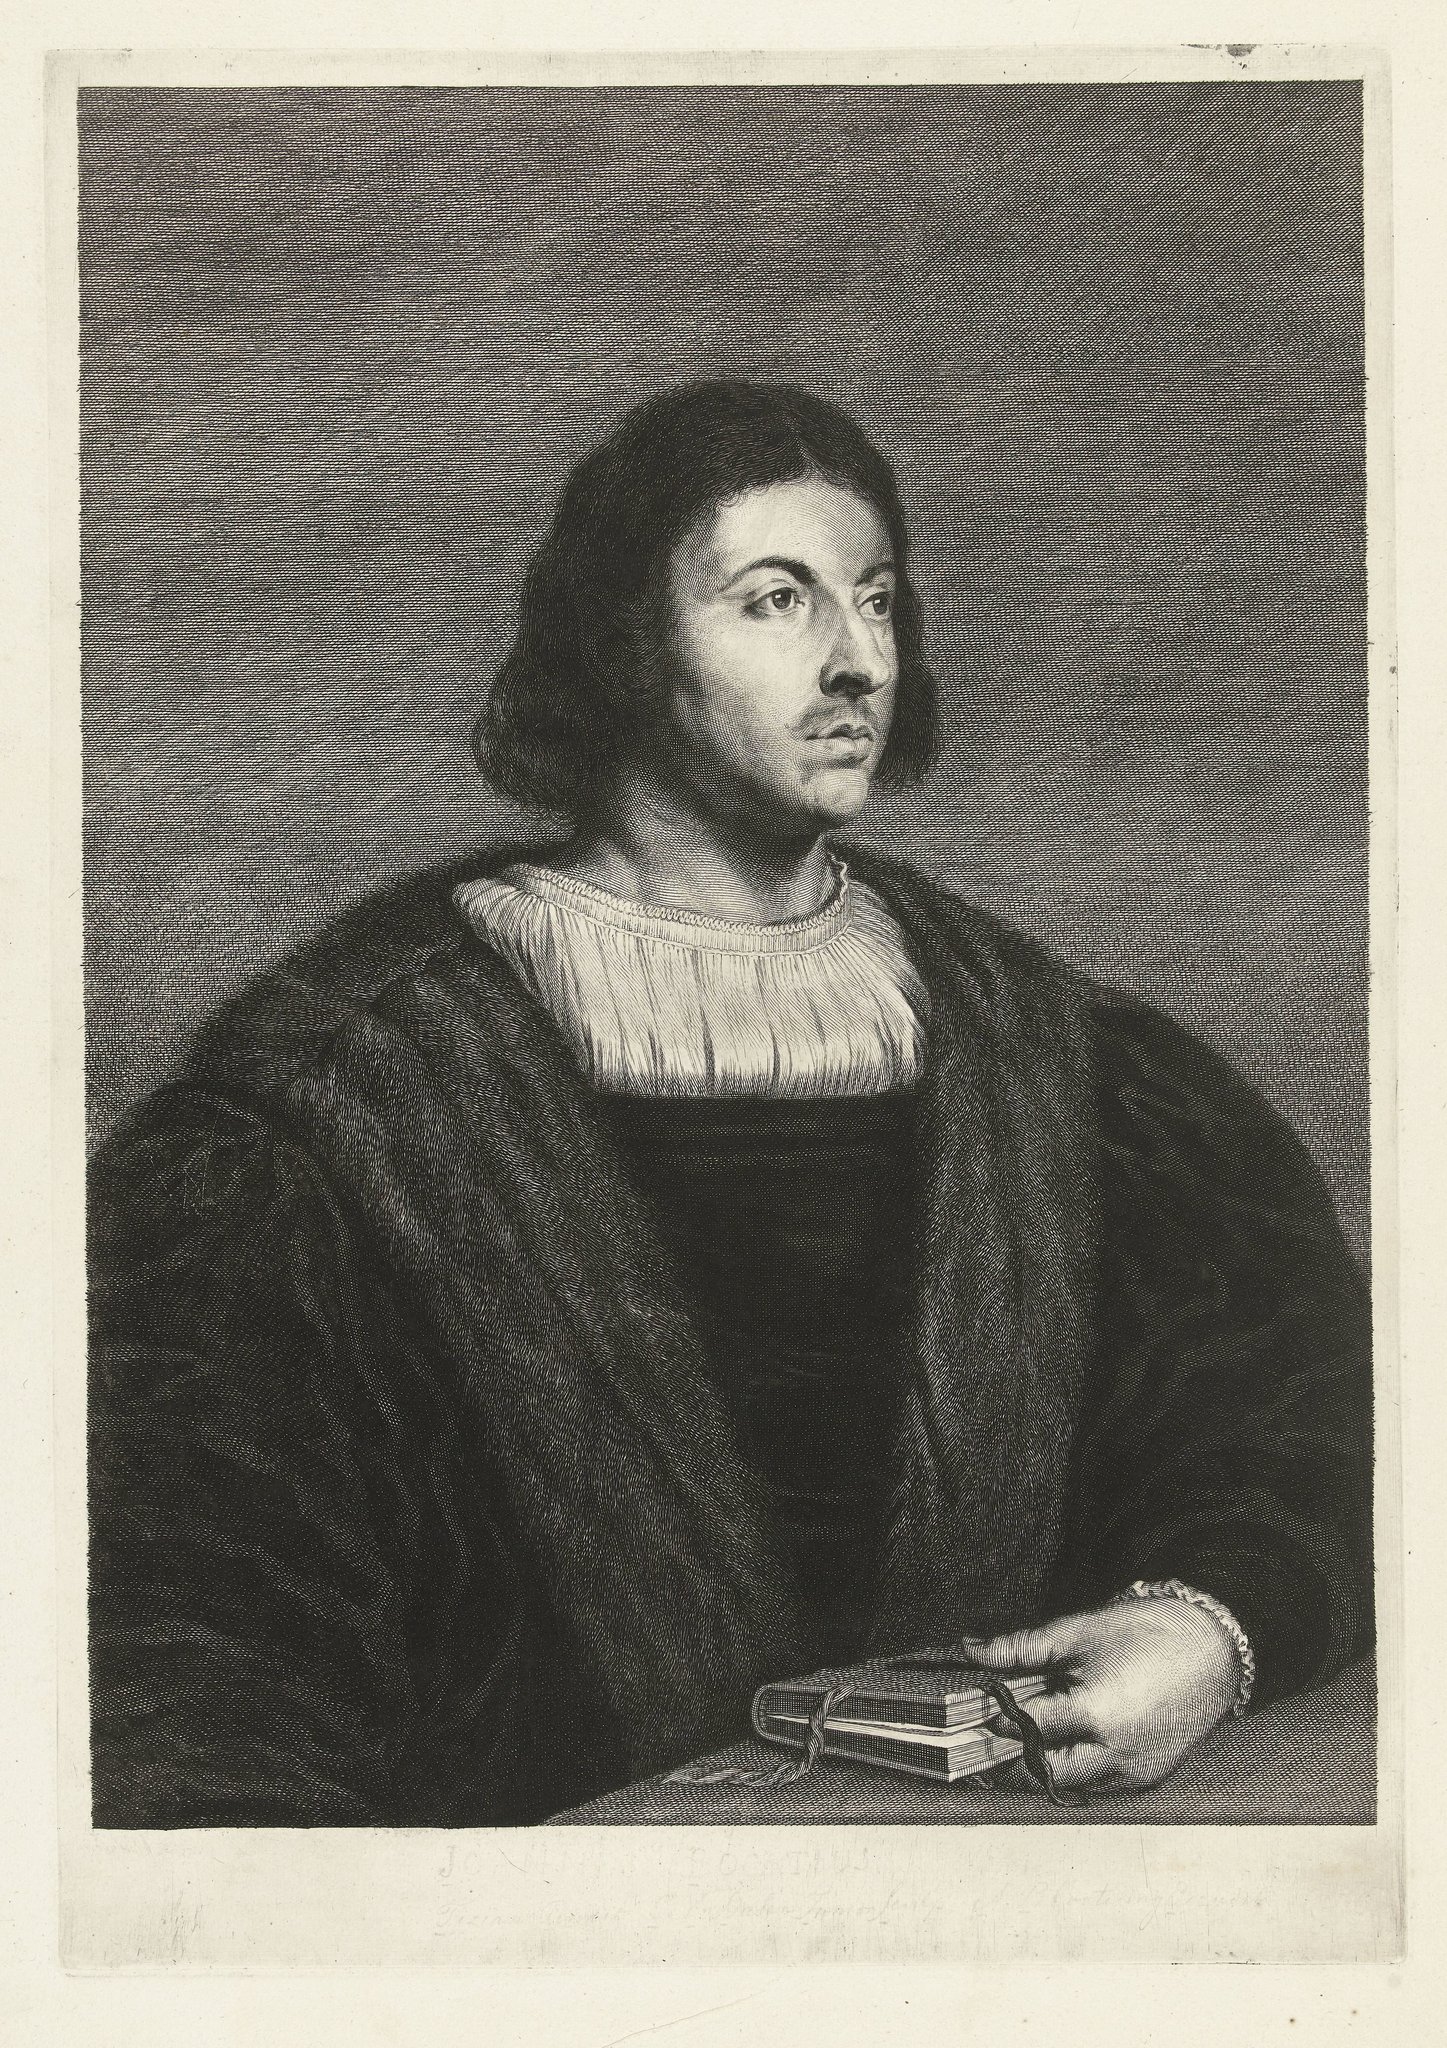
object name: print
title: Caelaturae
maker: cornelis van dalen (ii)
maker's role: draughtsman, print maker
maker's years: 1638-1664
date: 1648-1664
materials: paper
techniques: engraving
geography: amsterdam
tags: giovanni boccaccio, bard, lyric poet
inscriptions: collector's mark: Lugt 2165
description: Prent naar schilderij van Titiaan. Prent uit serie Caelaturae met vierendertig reprodukties naar Italiaanse en Nederlandse schilders, vervaardigd door de allerbeste graveurs in opdracht van de verzamelaar Gerard Reynst. Vergelijk het Reynst album uit de verzameling van Michiel Hinloopen met vier portretten door Cornelis van Dalen (II) in eerste staten in het Rijksmuseum, zie Waals 1988, p. 103, 104.